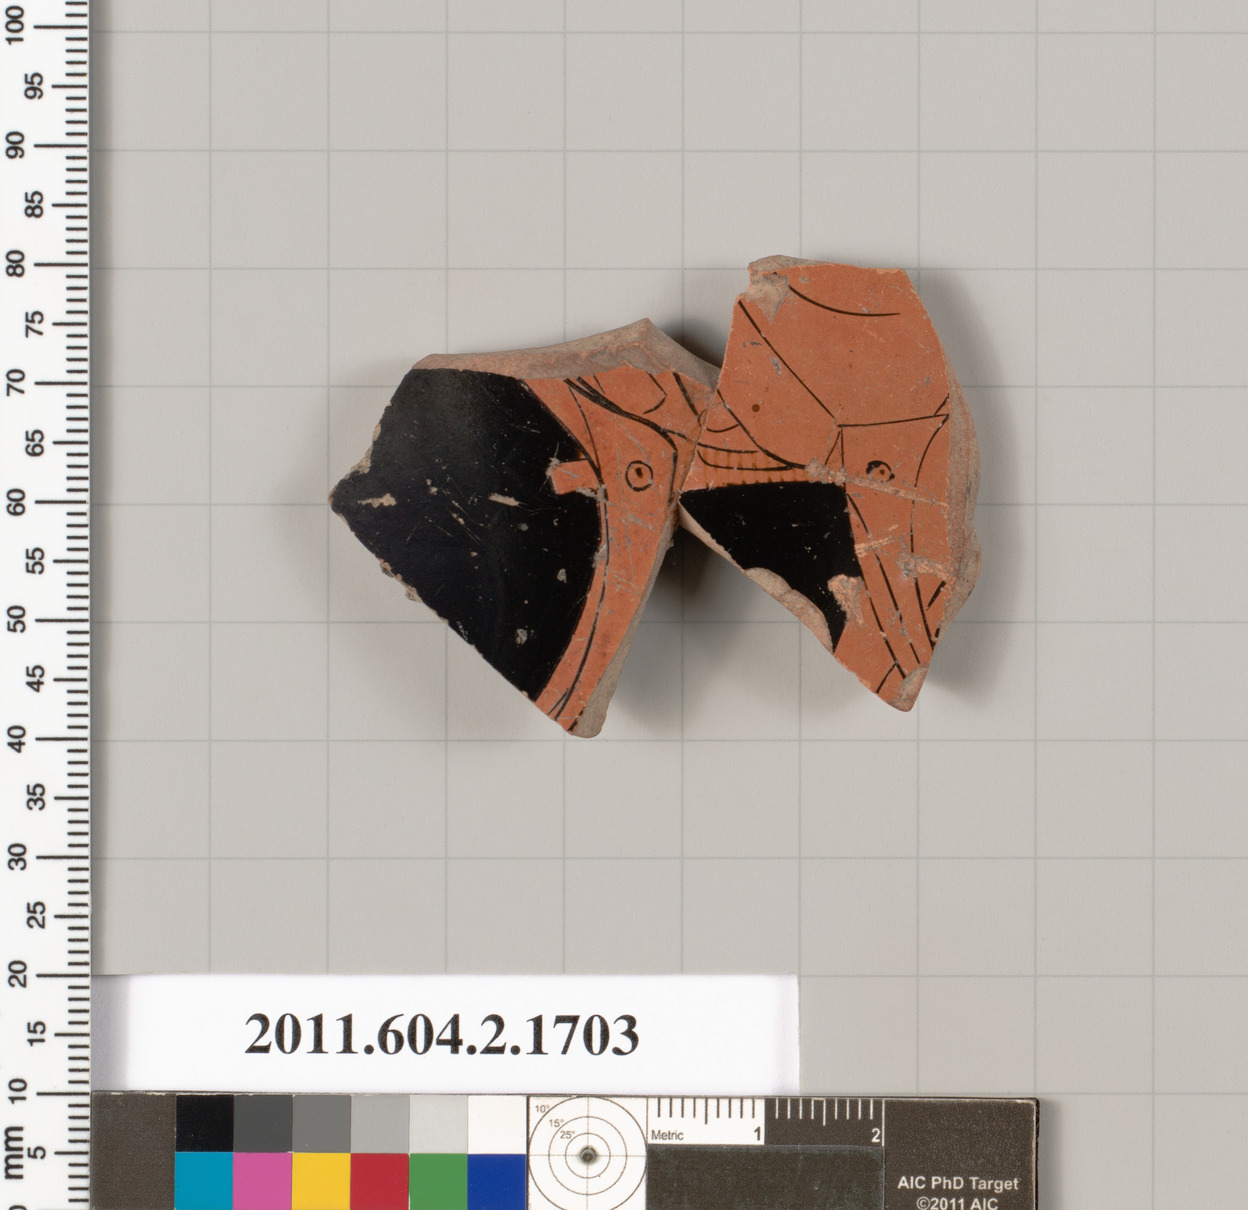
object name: skyphos fragment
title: Terracotta fragment of a skyphos (deep drinking cup)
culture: greek, attic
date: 450-426 BCE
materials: terracotta